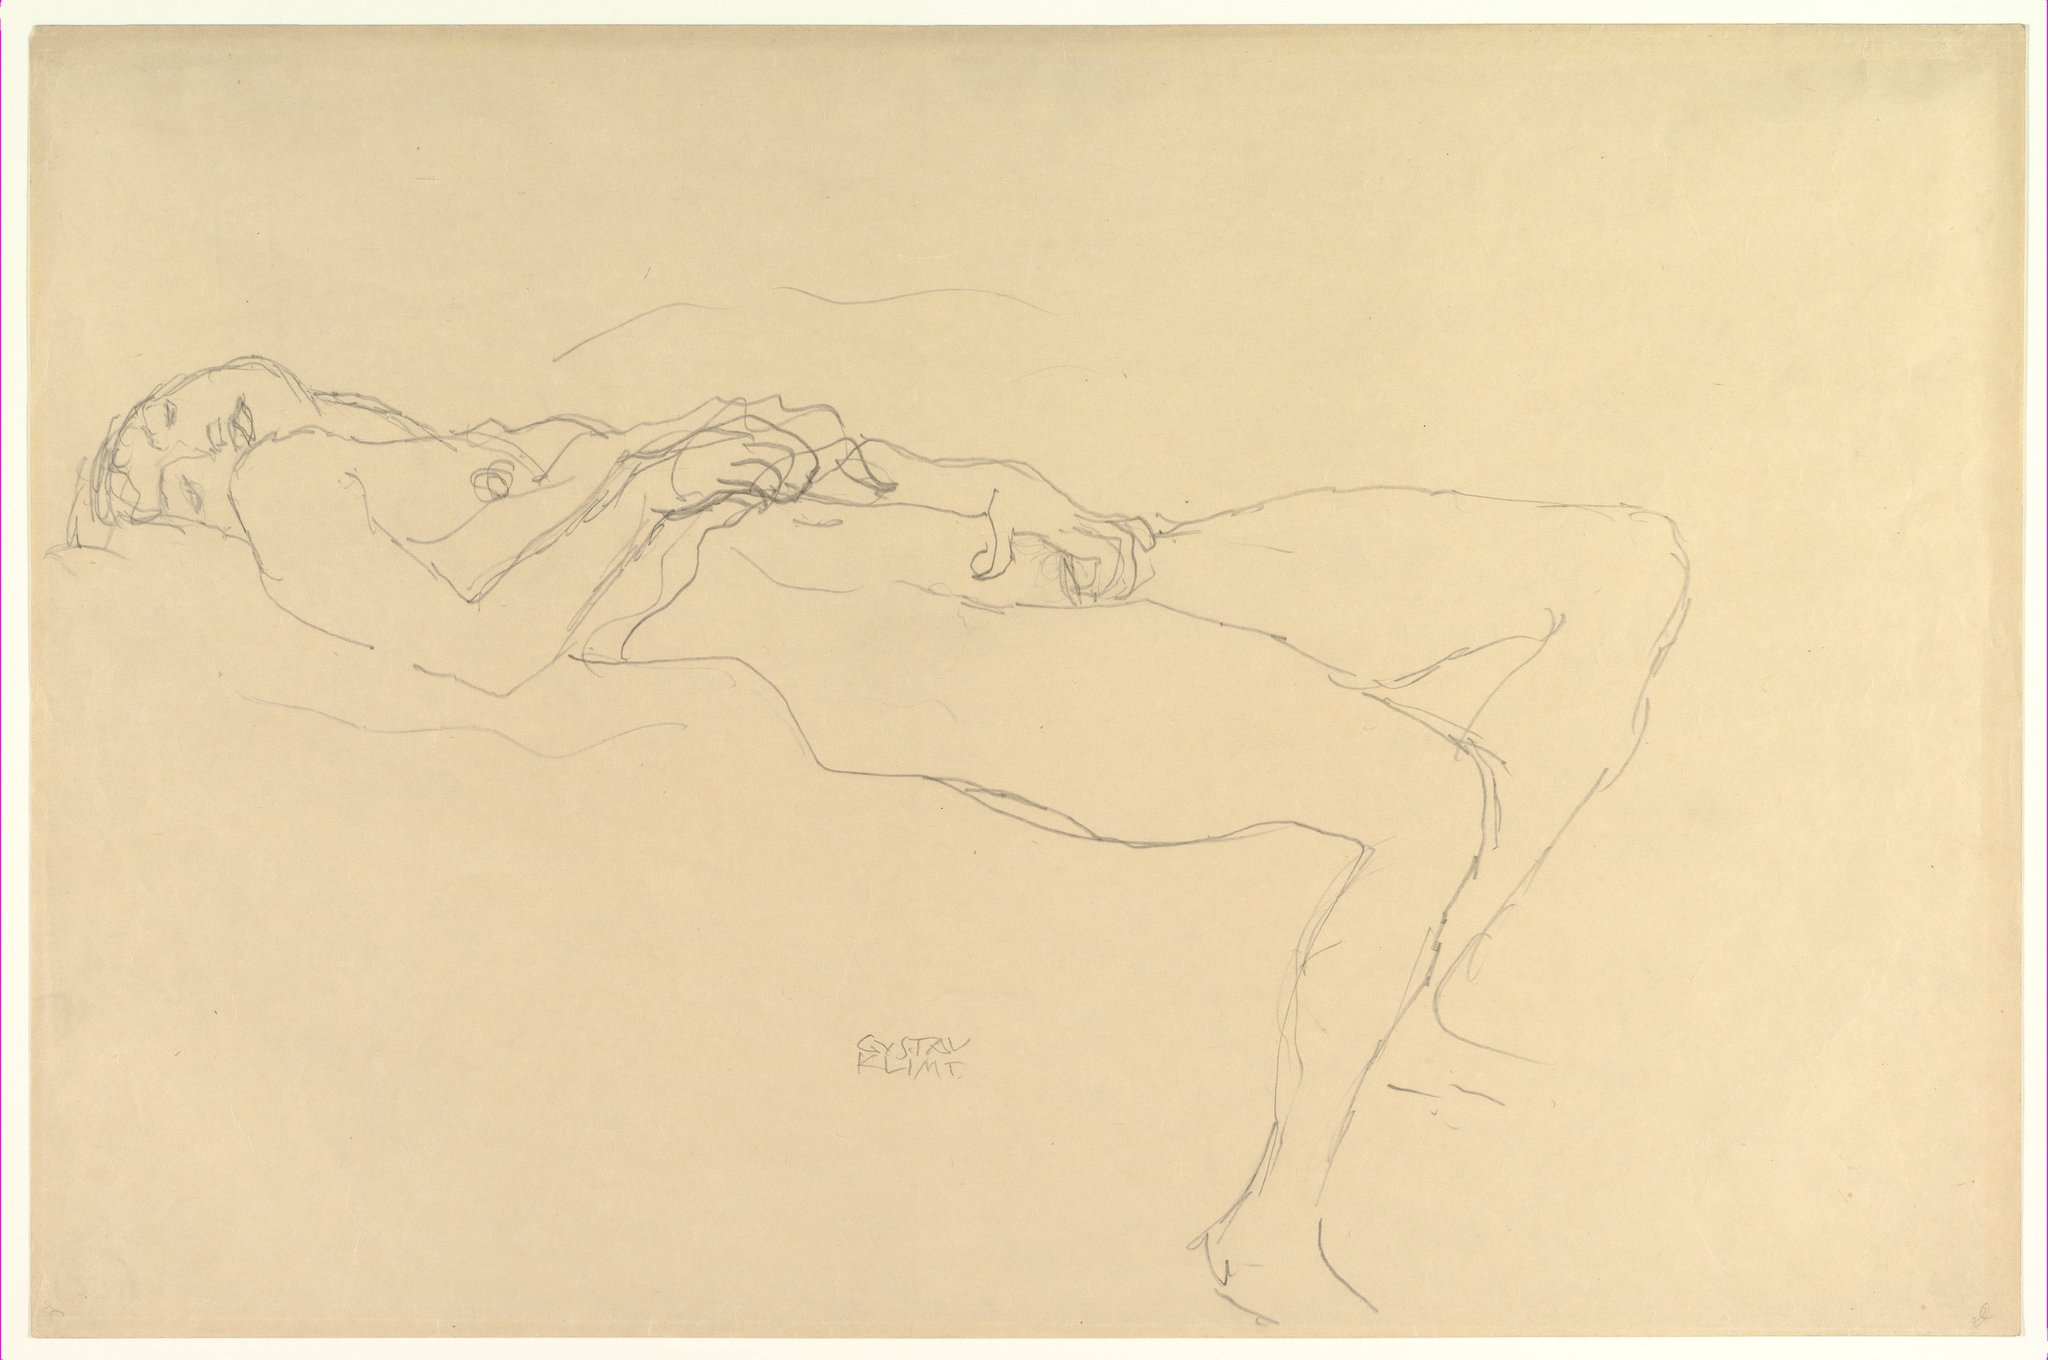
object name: drawing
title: Reclining Nude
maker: gustav klimt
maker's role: artist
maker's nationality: austrian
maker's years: 1862-1918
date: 1912-1913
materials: graphite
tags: female nudes